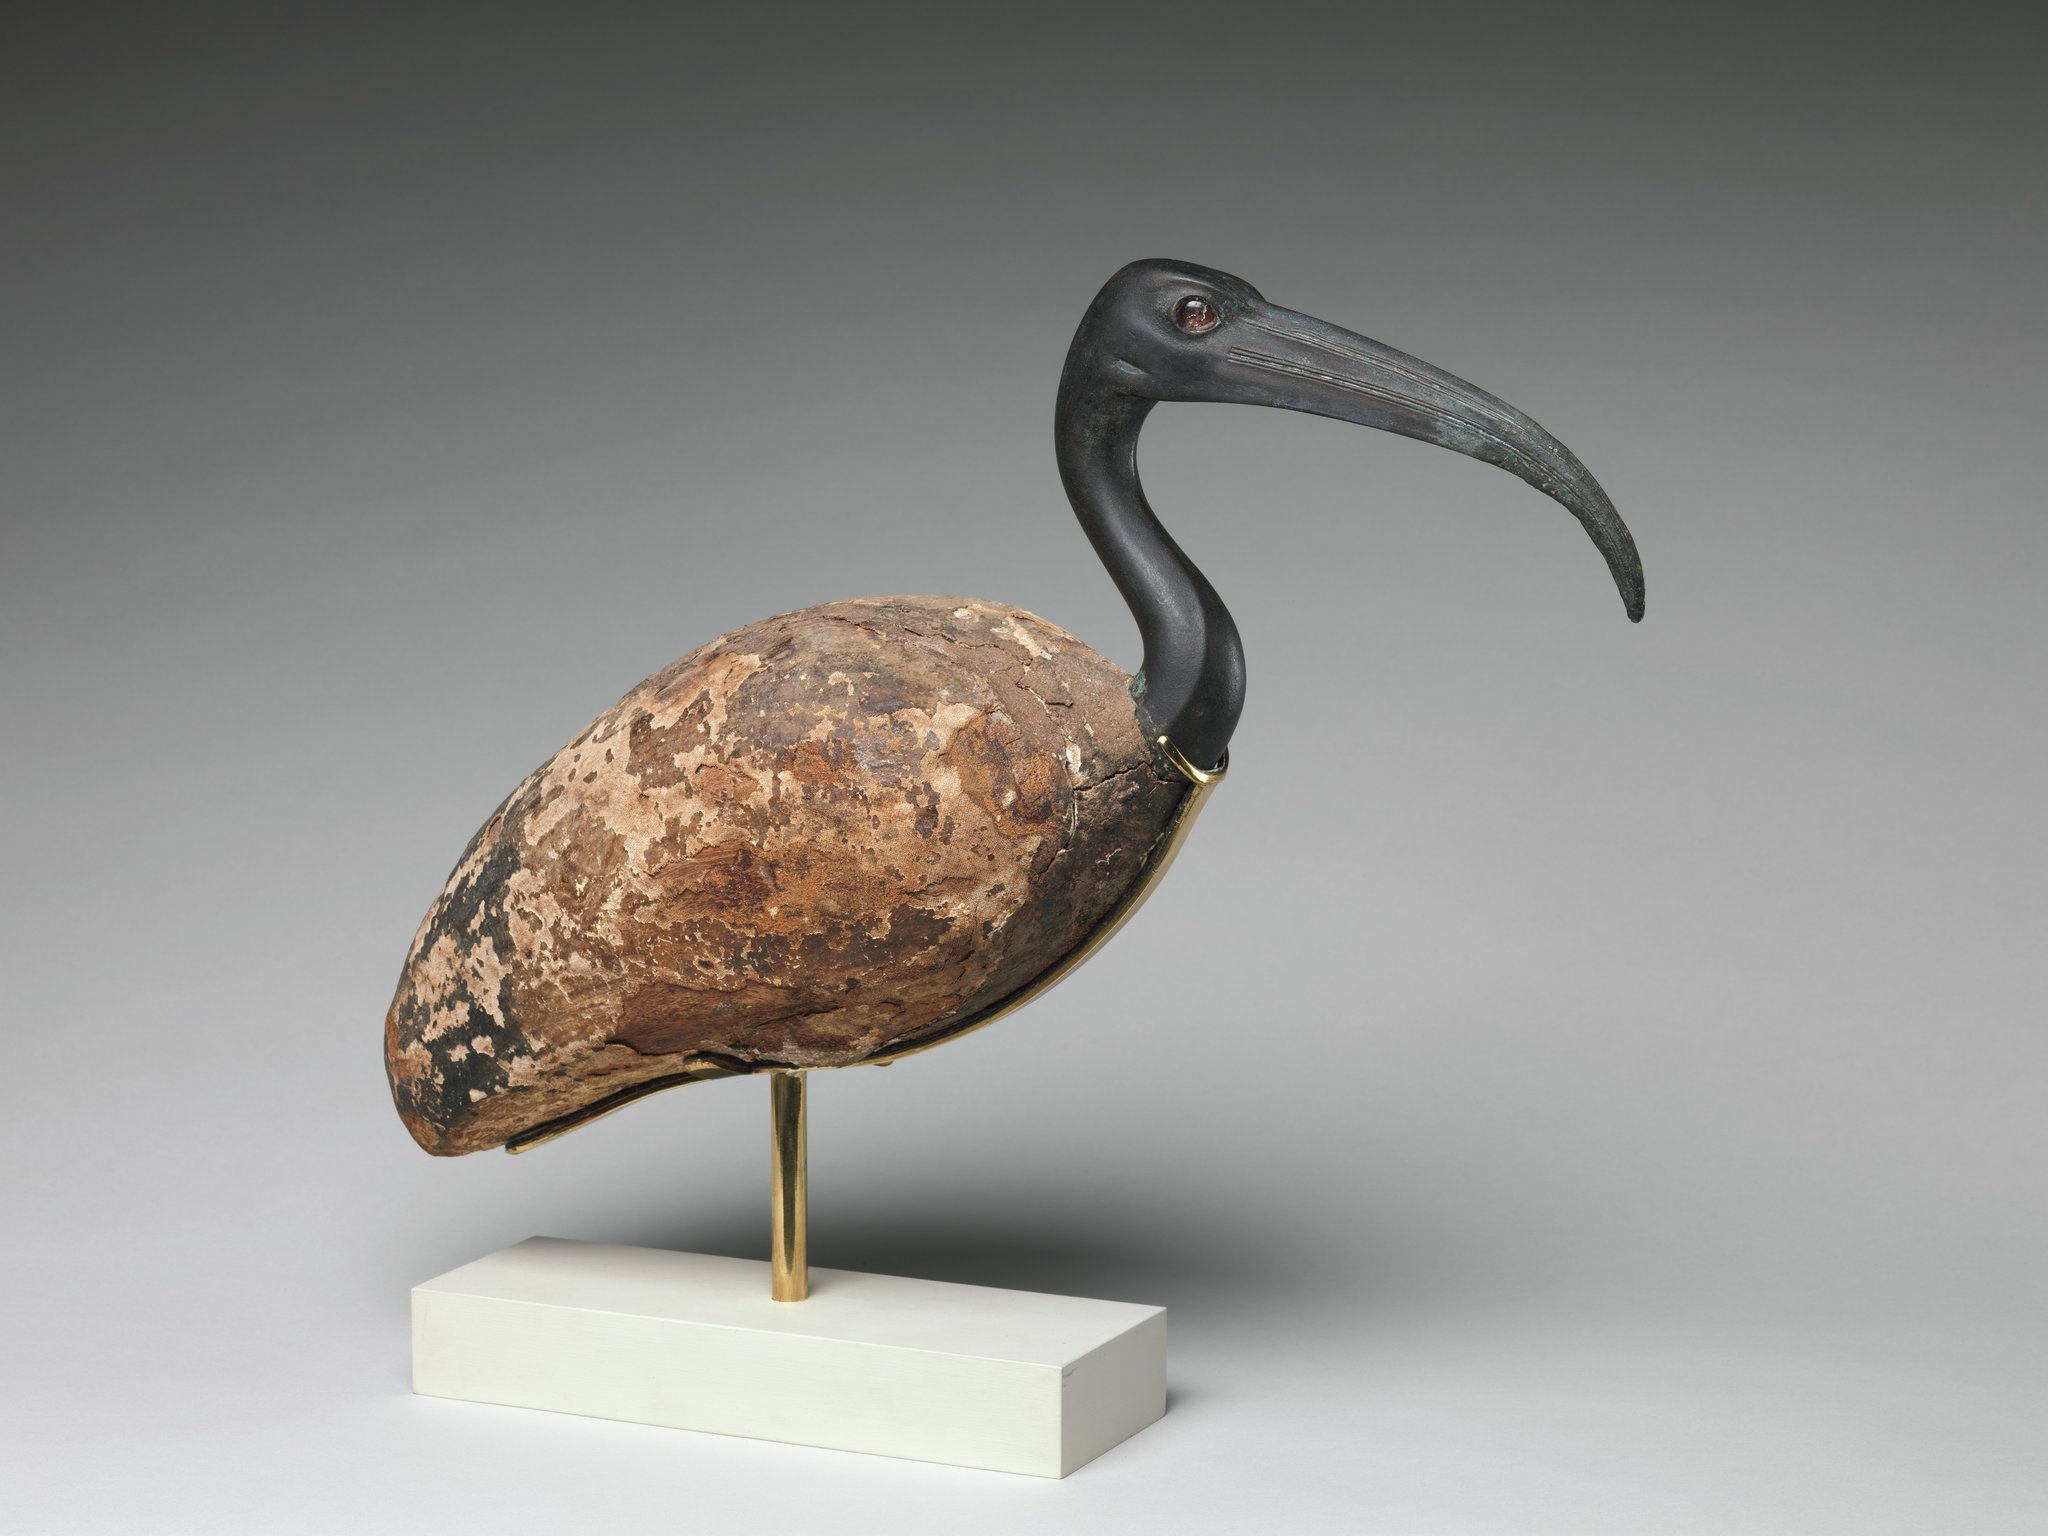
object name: figure, ibis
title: Ibis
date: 600-30 BCE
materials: bronze, gesso, glass, linen, paint, wood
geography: middle egypt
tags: birds